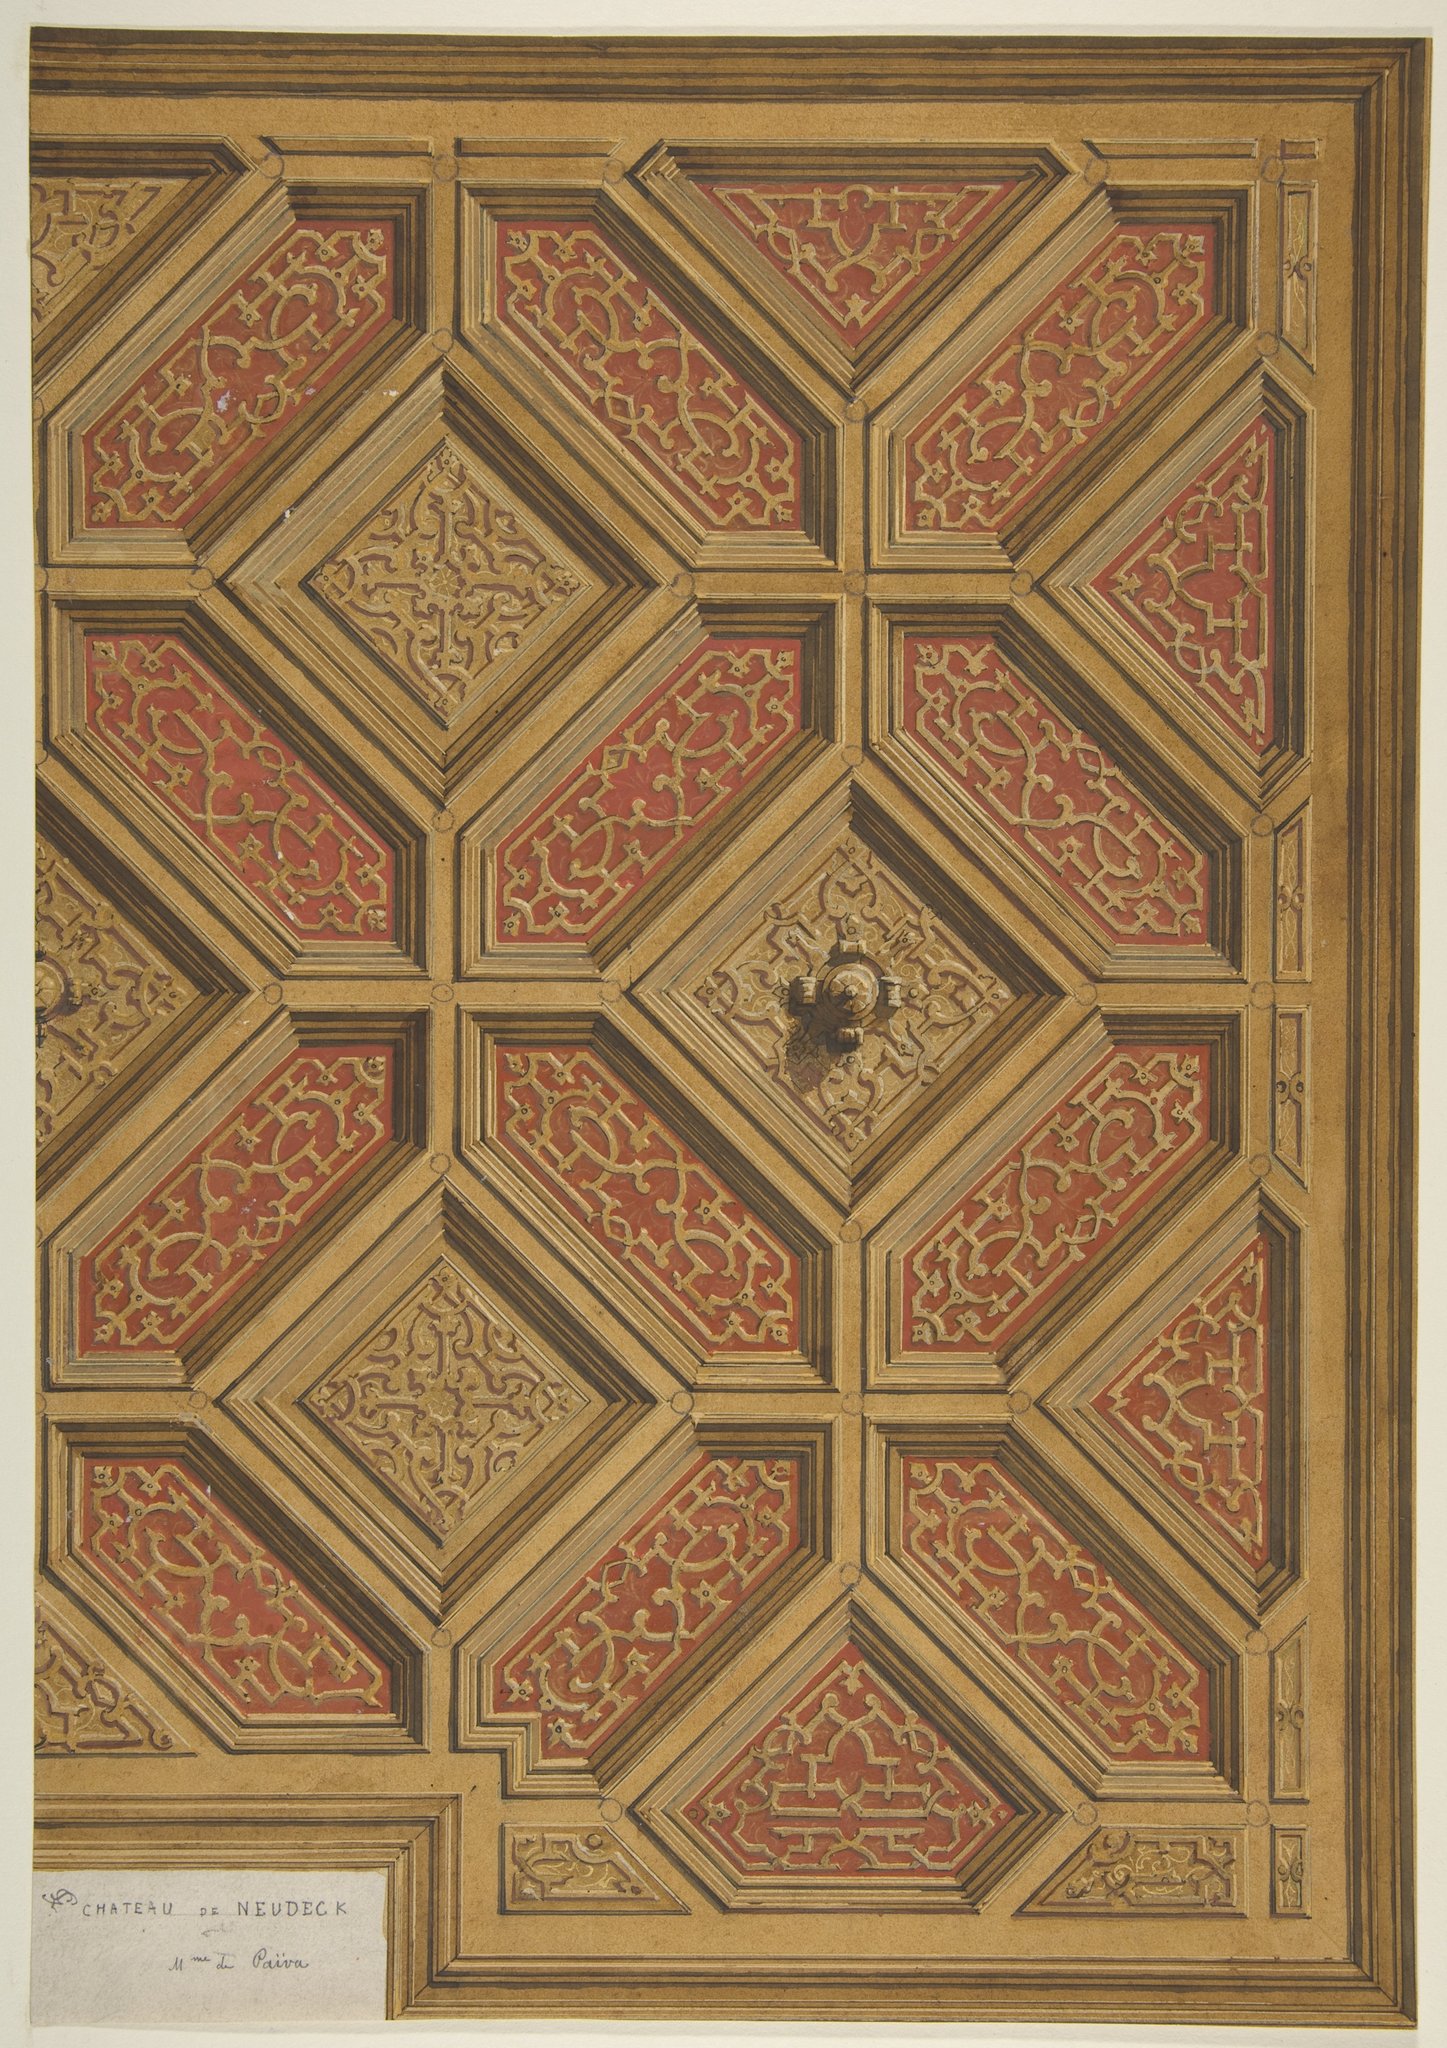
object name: drawing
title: Design for Coffered Ceiling, Mme Païva's Chateau at Neudeck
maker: jules-edmond-charles lachaise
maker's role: artist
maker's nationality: french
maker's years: 1897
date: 1851-1900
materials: gilt, gouache, ink, watercolor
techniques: pen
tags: ceilings